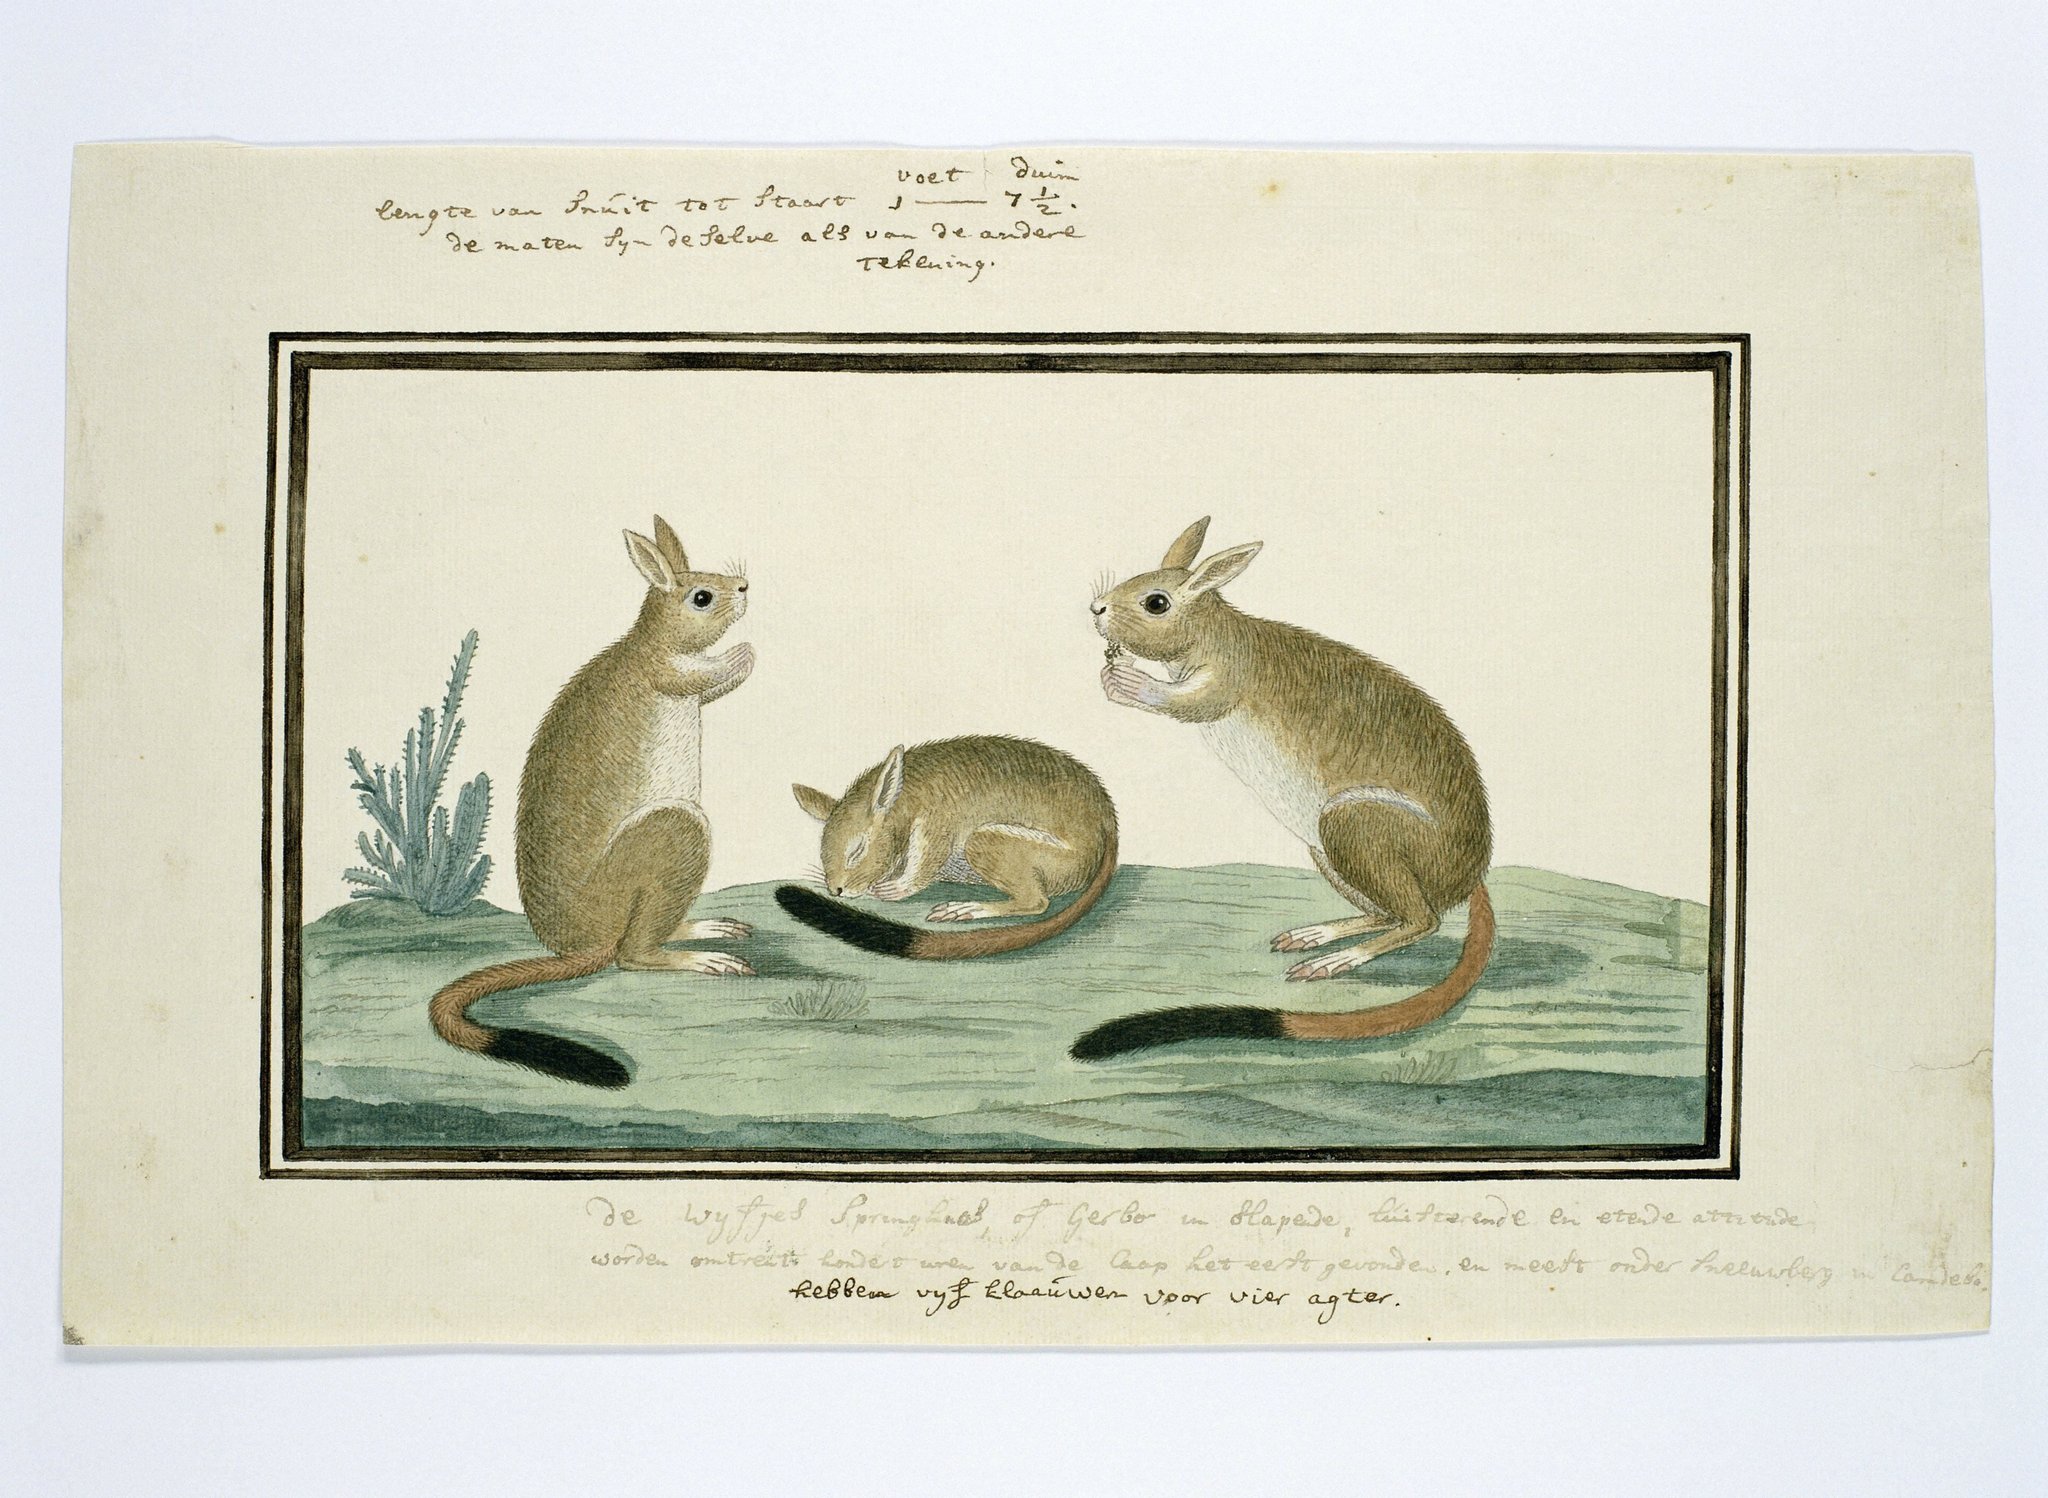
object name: album leaf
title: Pedetes cafer (South African springhare)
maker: robert jacob gordon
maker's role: draughtsman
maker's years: 1743-1795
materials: paint, ink, paper, pencil, watercolor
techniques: brush, pen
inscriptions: annotation: ‘boen: afmetingen in voet en duim; onder: de wijfjes Springhaas, of Gerbo in slapende, luisterende en etende attitude / [...].’